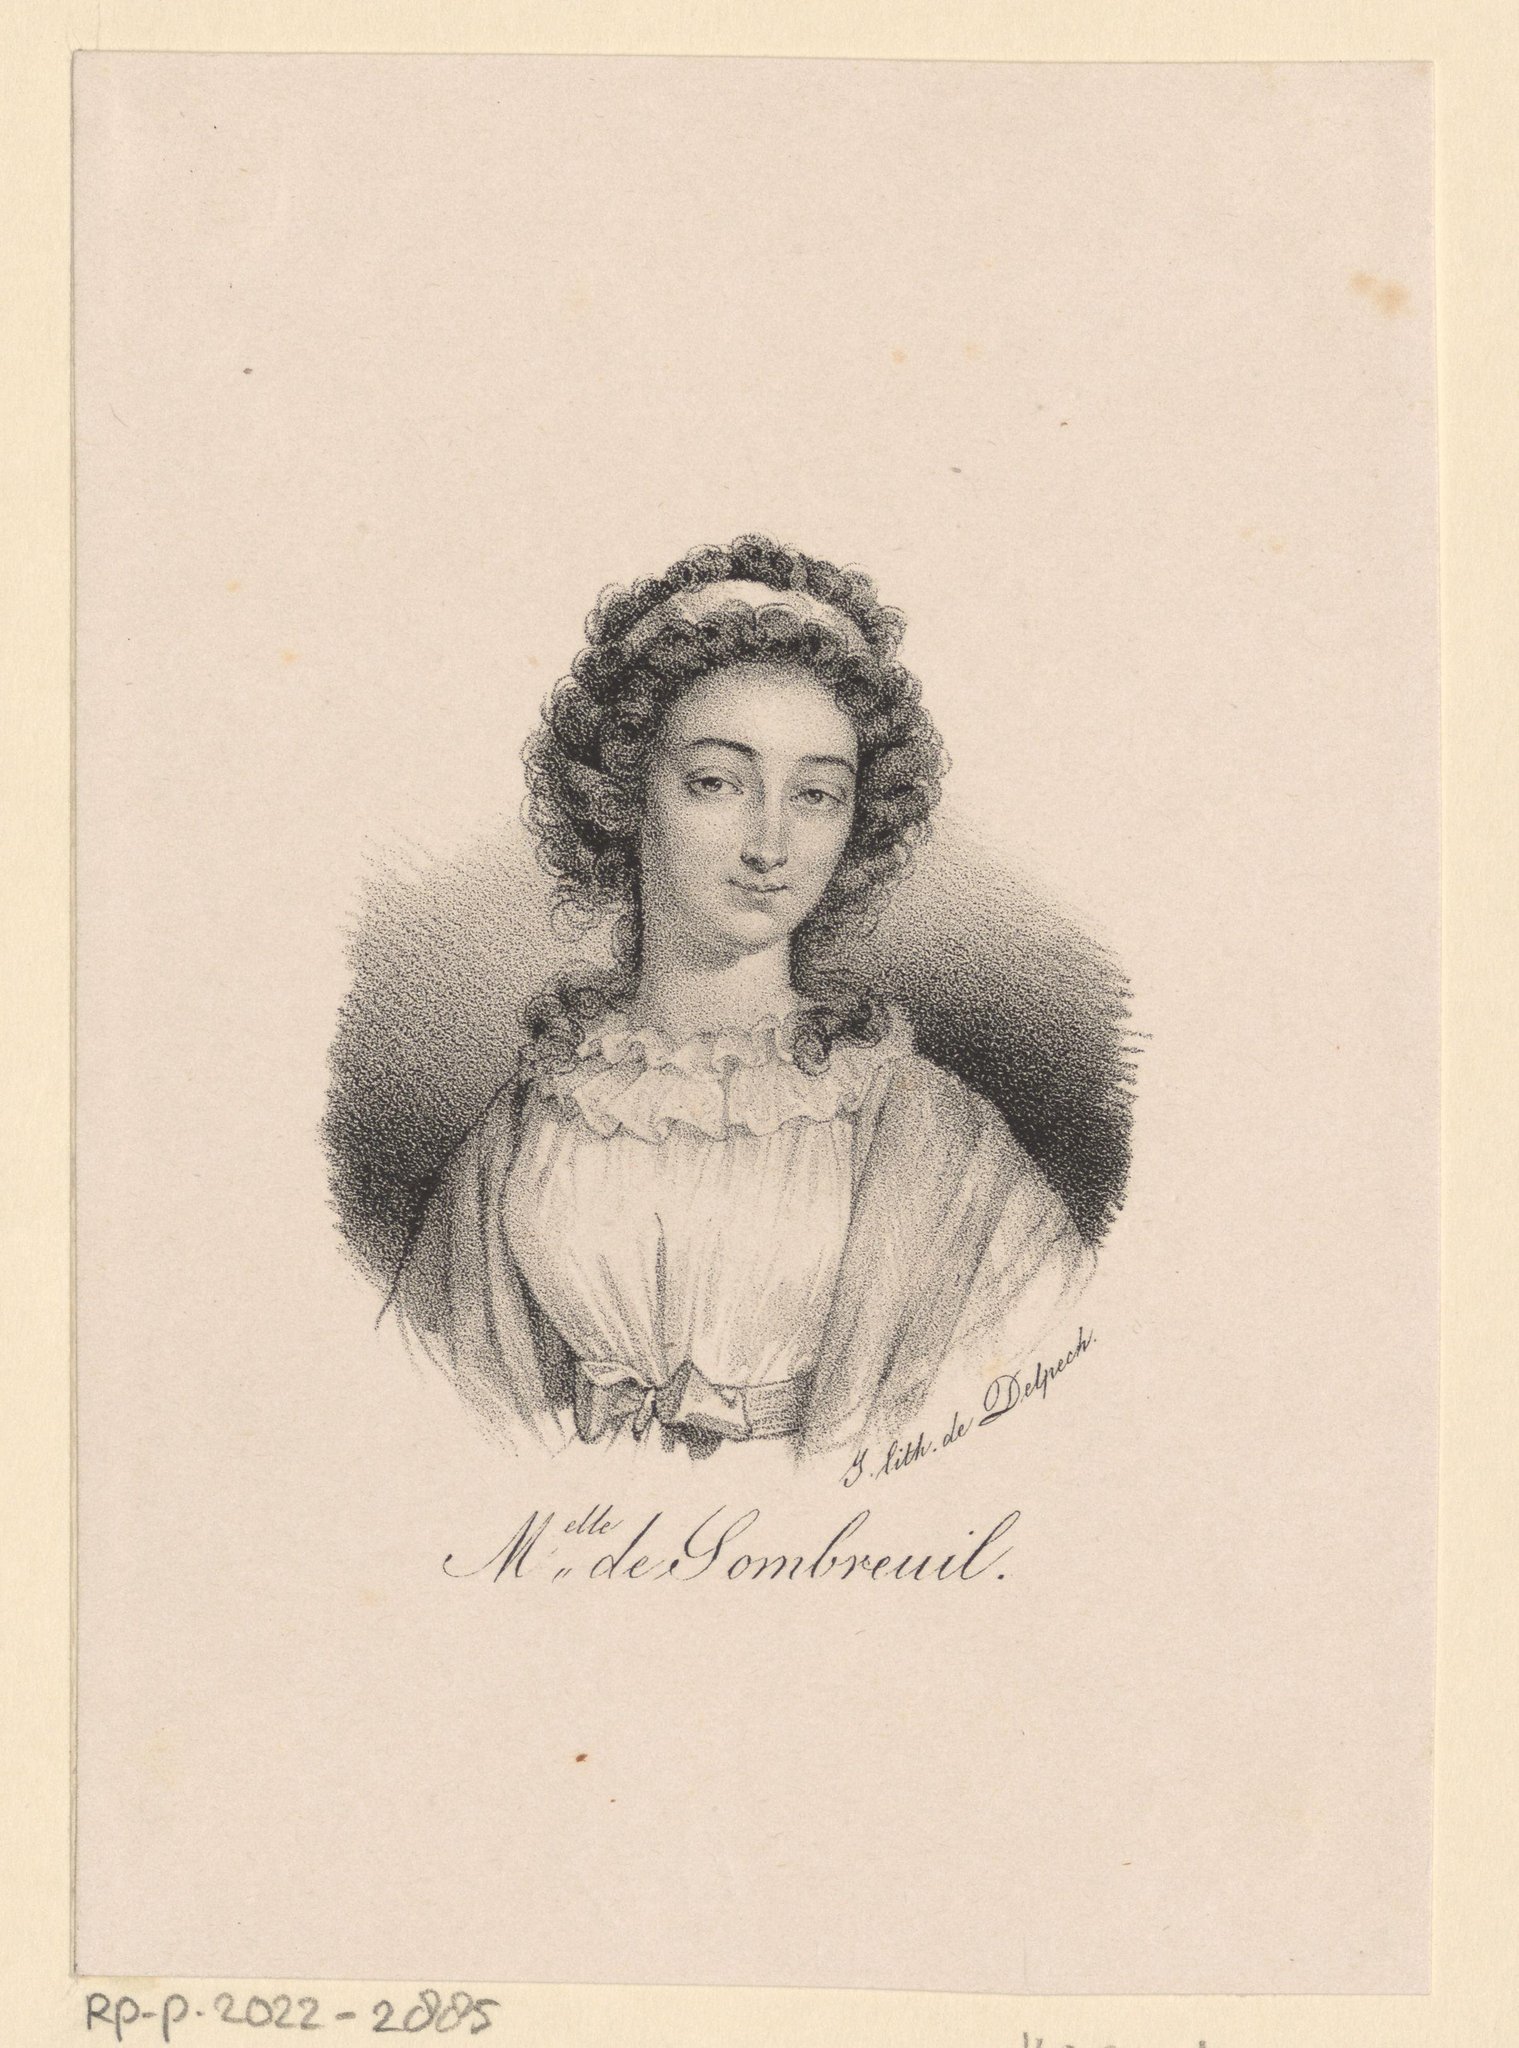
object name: print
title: Portret van Marie-Maurille de Sombreuil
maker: Anonymous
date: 1818-1842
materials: paper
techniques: lithograph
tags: historical persons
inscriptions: number: ‘1537’